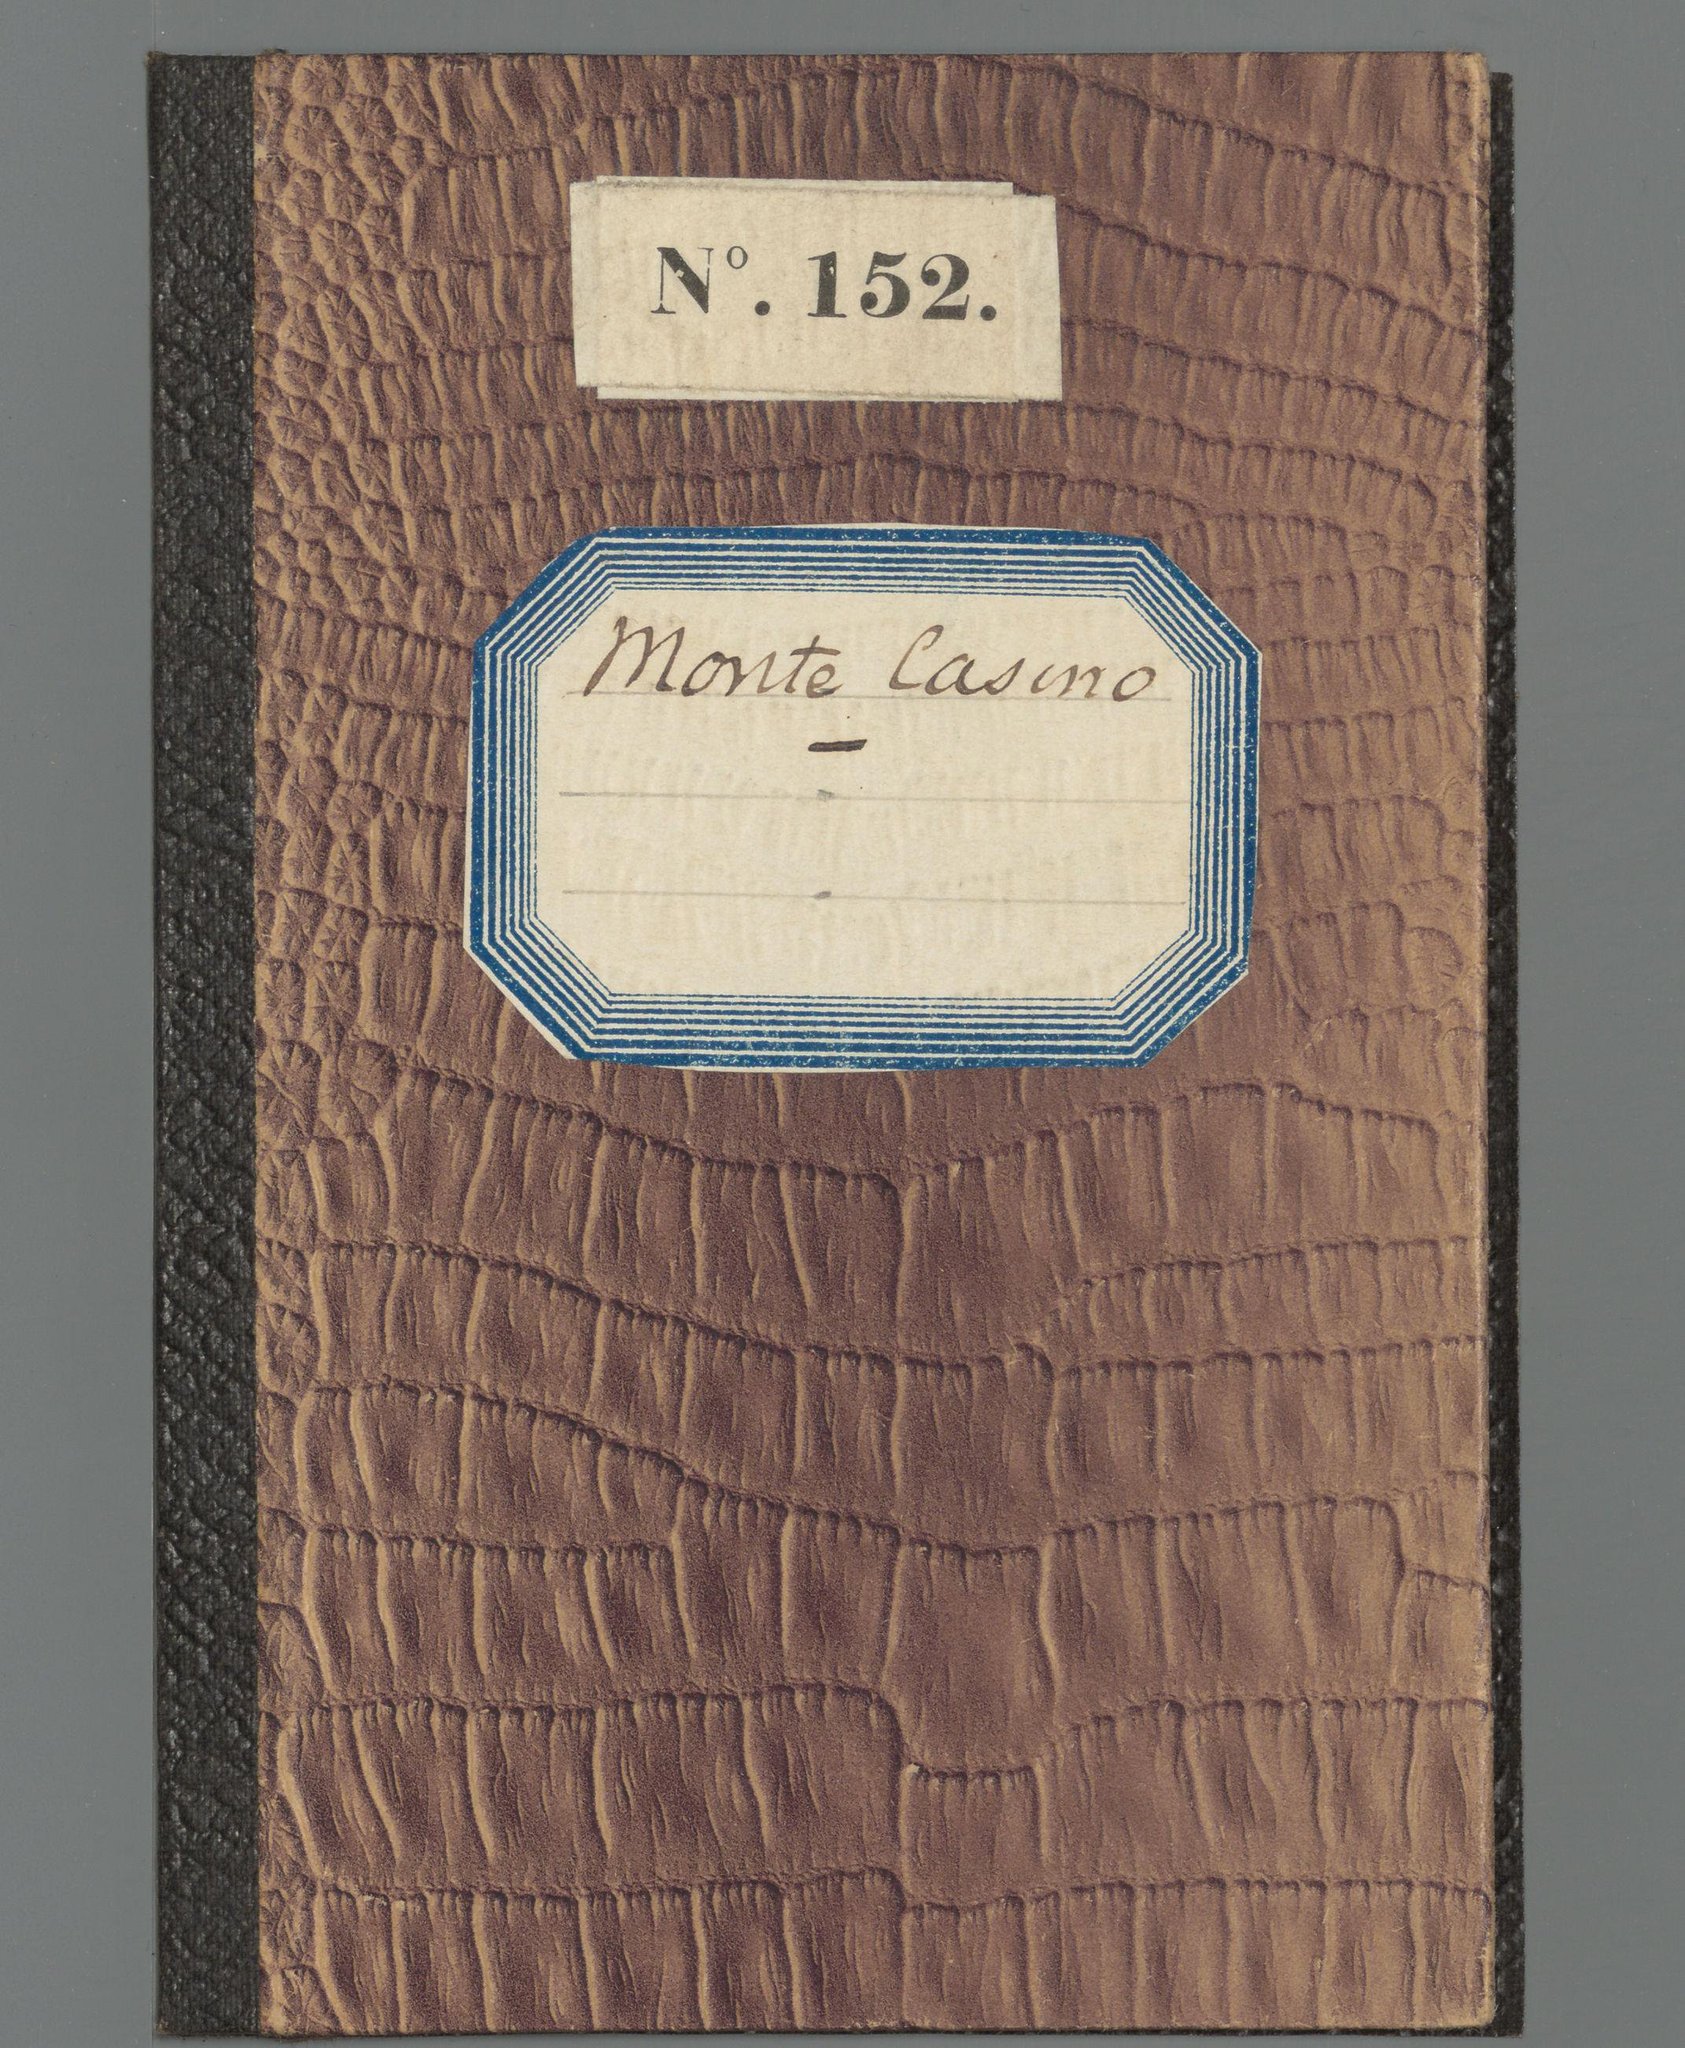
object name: wrapper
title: Omslag voor twintig prentbriefkaarten van de Abdij van Montecassino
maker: Anonymous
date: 1900-1950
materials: cardboard, ink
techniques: pen